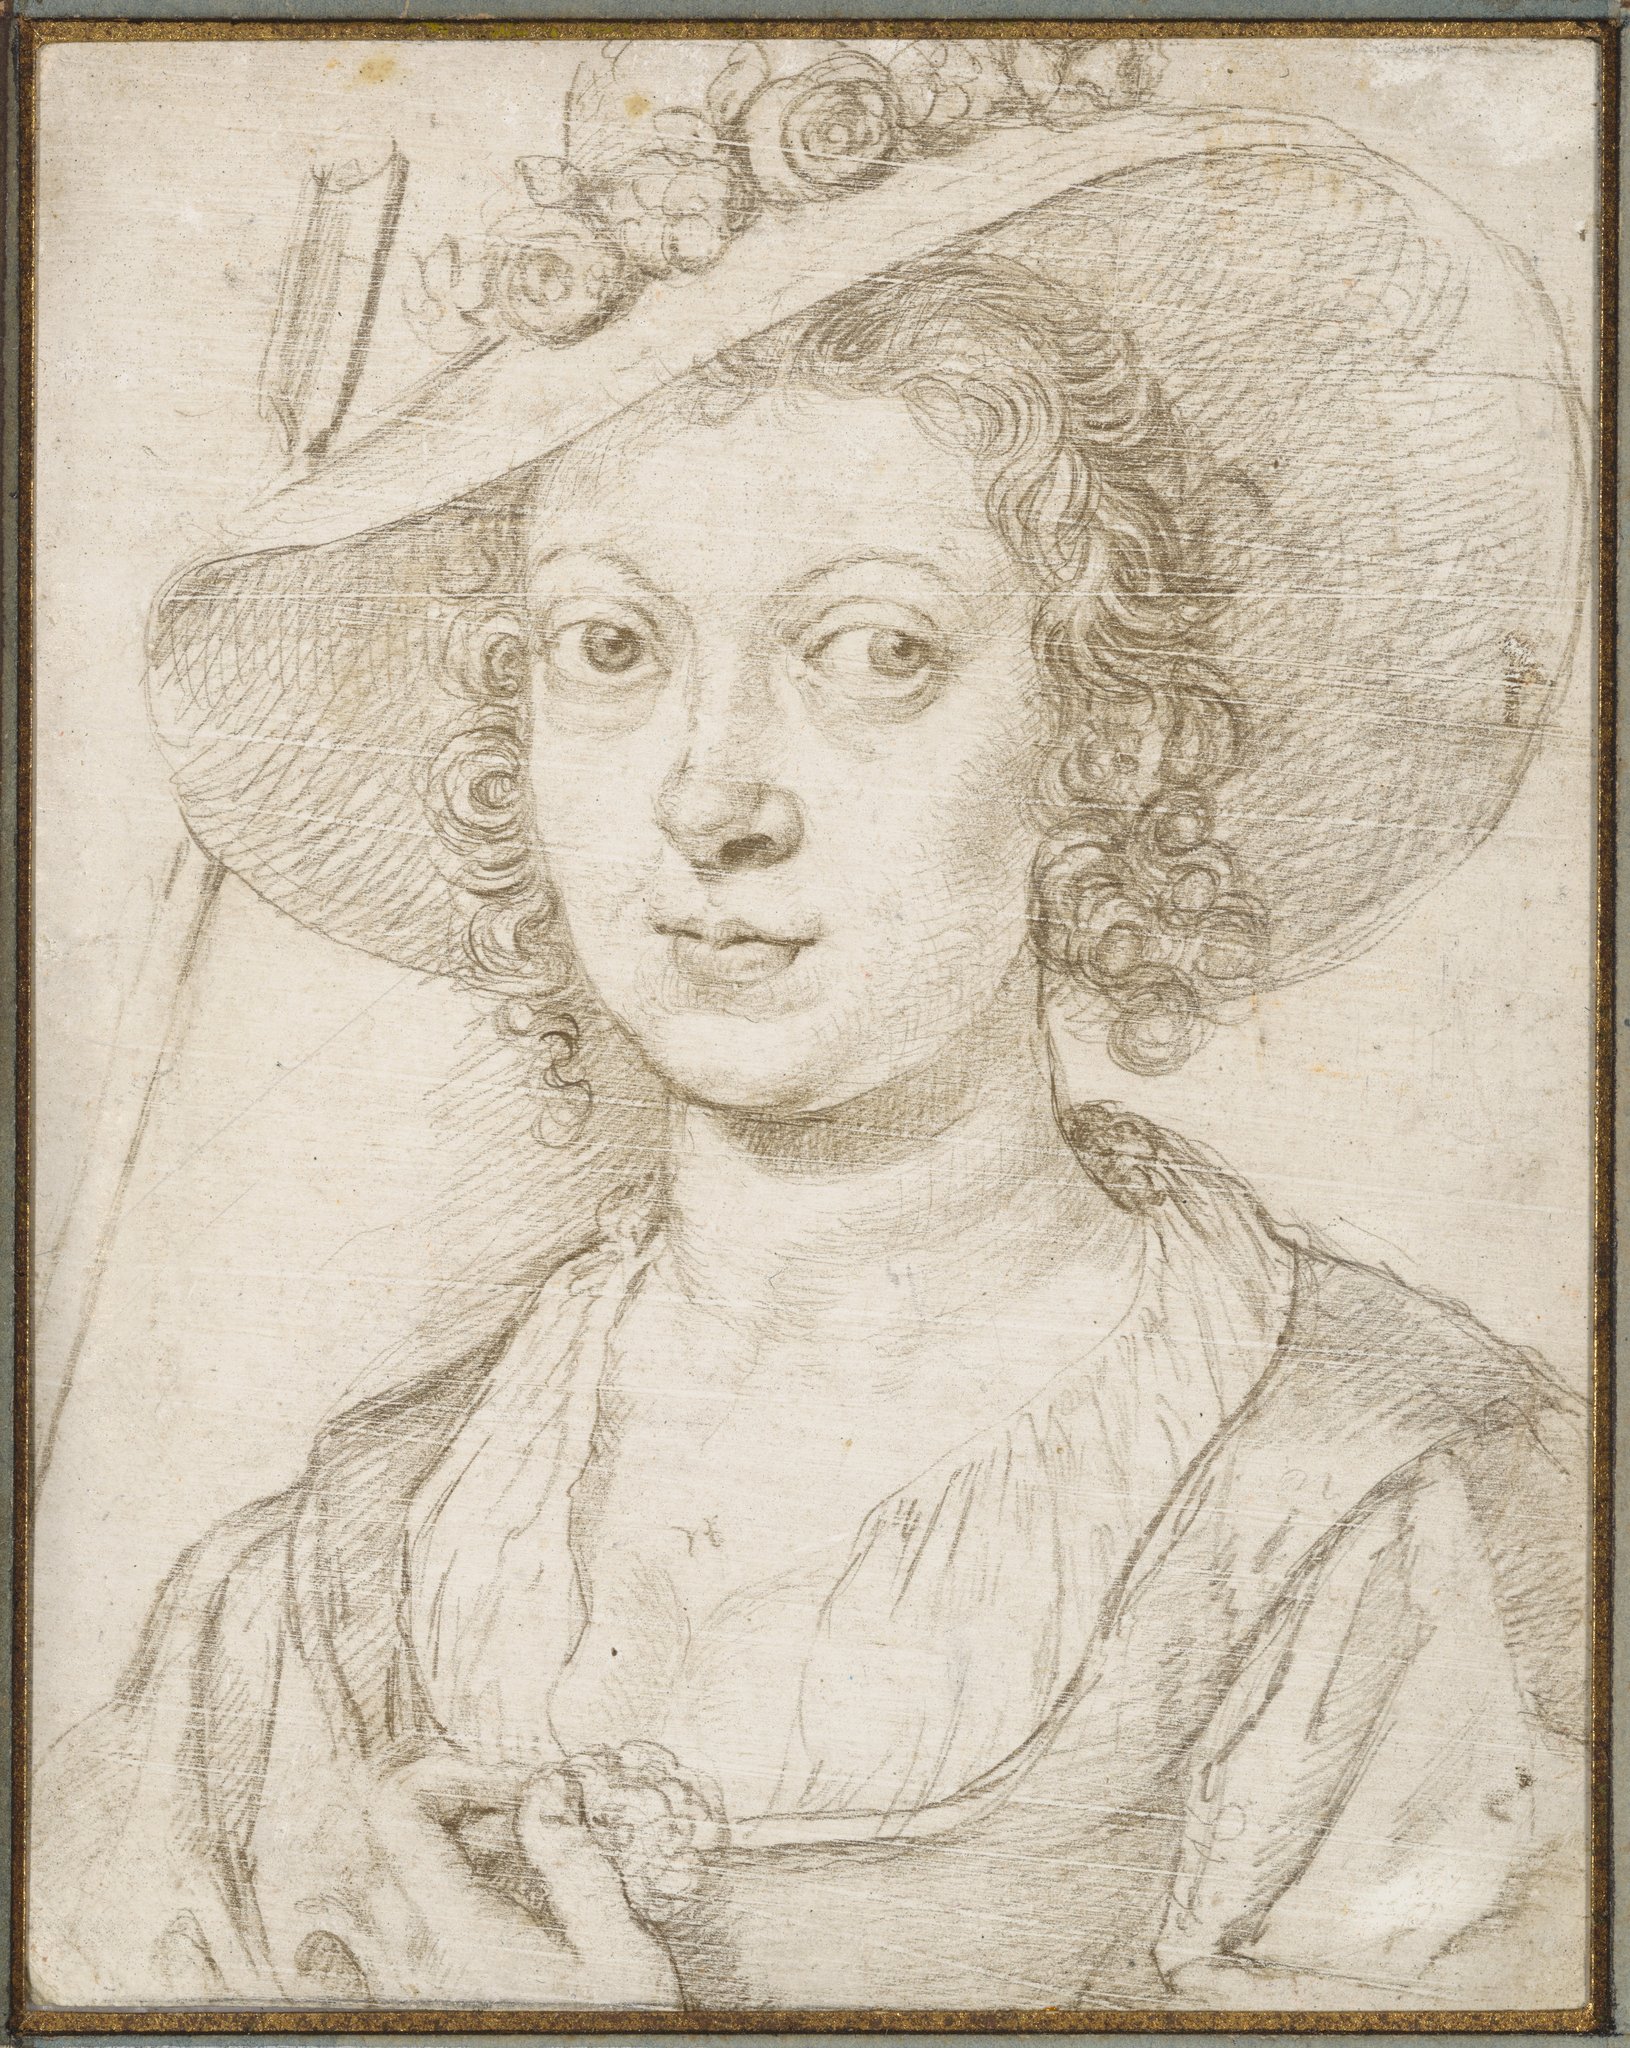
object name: drawing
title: Portrait of a woman as a shepherdess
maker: crispijn de passe the younger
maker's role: artist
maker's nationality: dutch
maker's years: 1590-1670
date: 1635-1640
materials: parchment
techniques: painting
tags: portraits,women